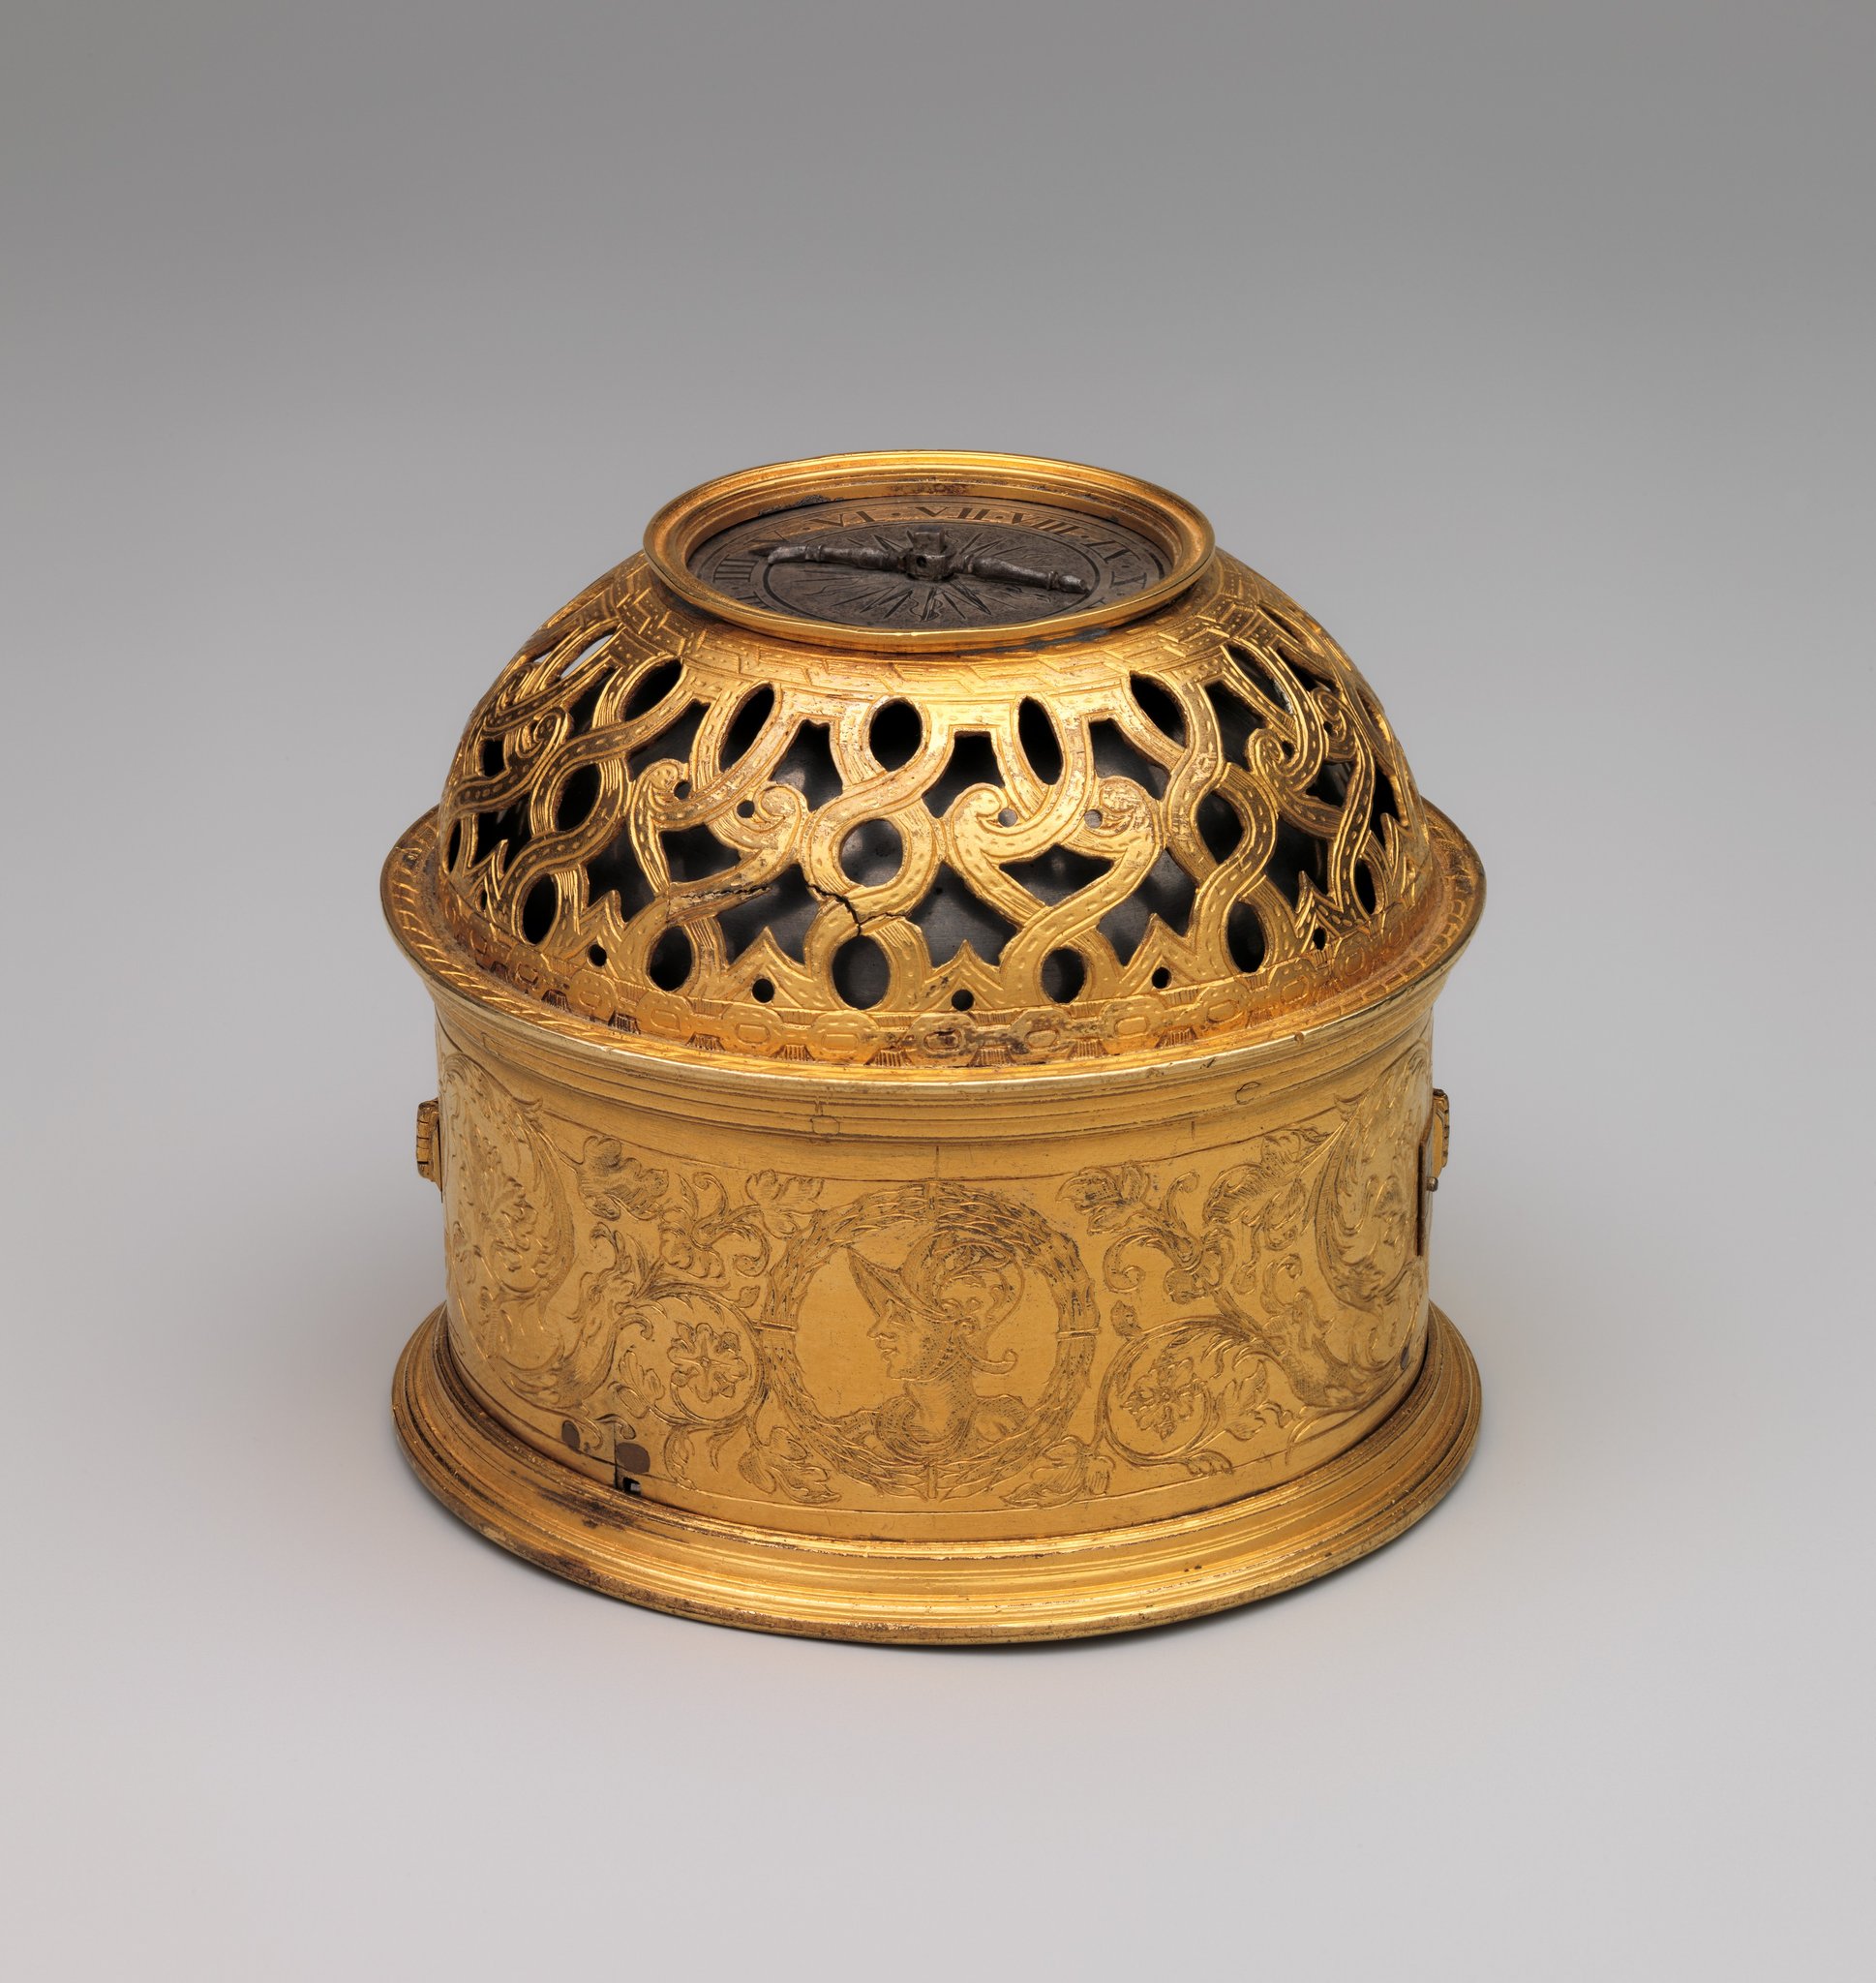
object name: table clock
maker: bartholomew newsam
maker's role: maker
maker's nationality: british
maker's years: 1487-1587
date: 1580-1585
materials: brass, gilt brass, silver, steel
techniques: chasing, engraving